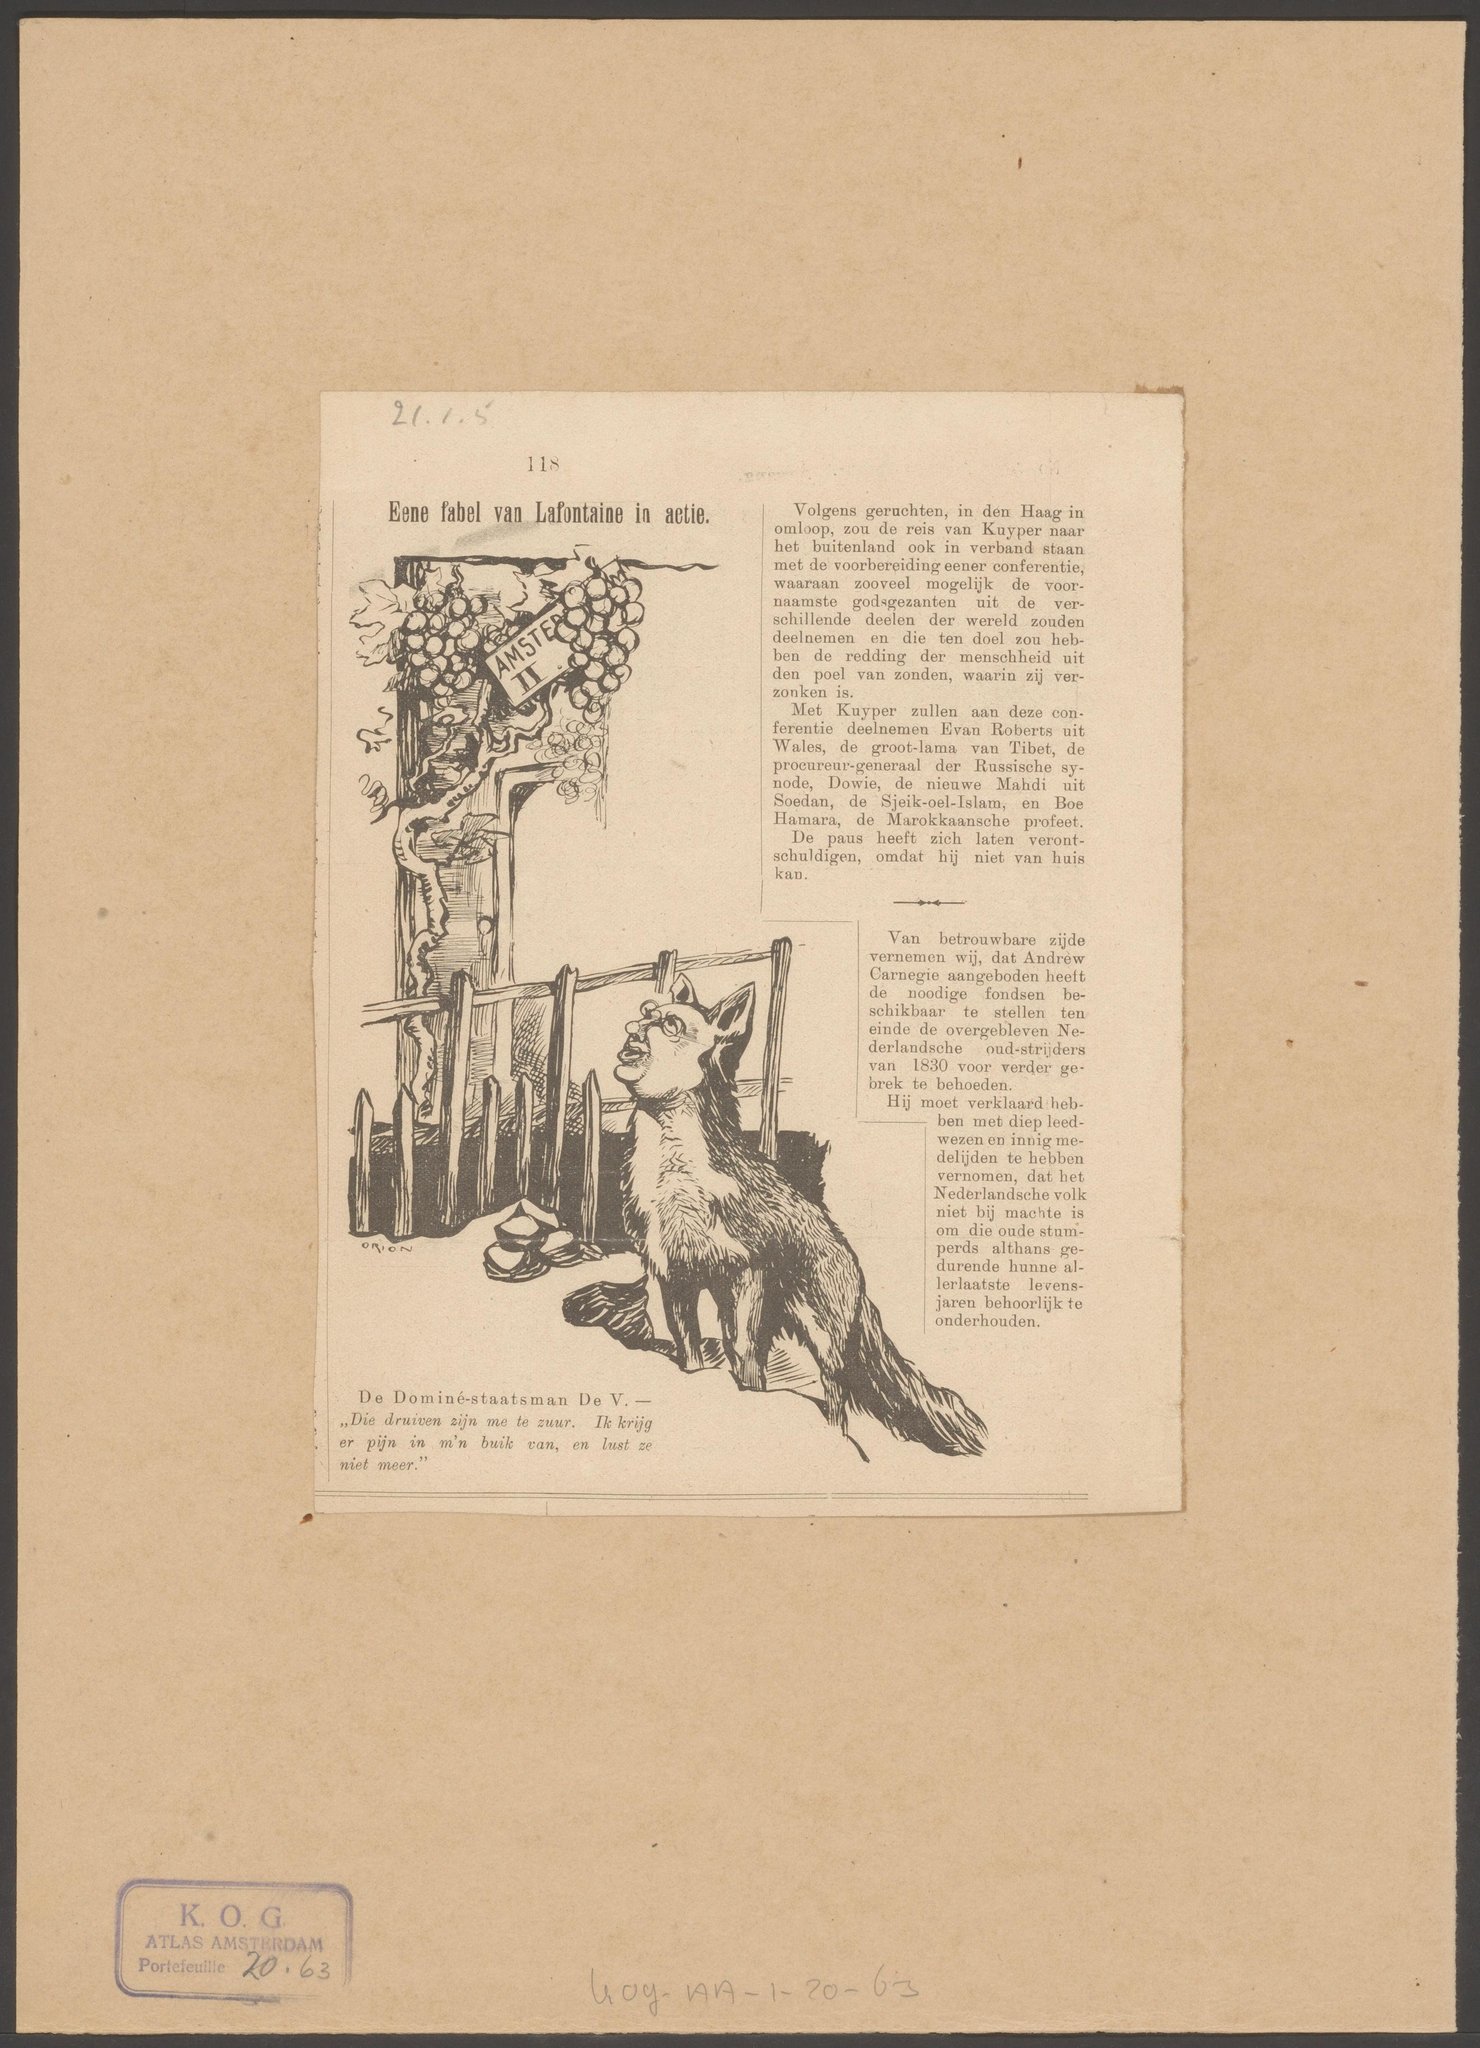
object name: cartoon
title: Johannes Theodoor de Visser als vos kijkt omhoog naar twee druiventrossen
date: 1905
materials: paper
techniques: letterpress printing, line block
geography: netherlands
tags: utrecht, the hague, fables of lafontaine : use 85(...), voting, election, politician, e.g. party leader, bunch of grapes, political caricatures and satires, beasts of prey, predatory animals: fox, amsterdam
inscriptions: date: ‘21.1.5’, collector's mark: Lugt 1641b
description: Onderwerpsrubriek binnen de Atlas Amsterdam: Verkiezingen Tweede Kamer.